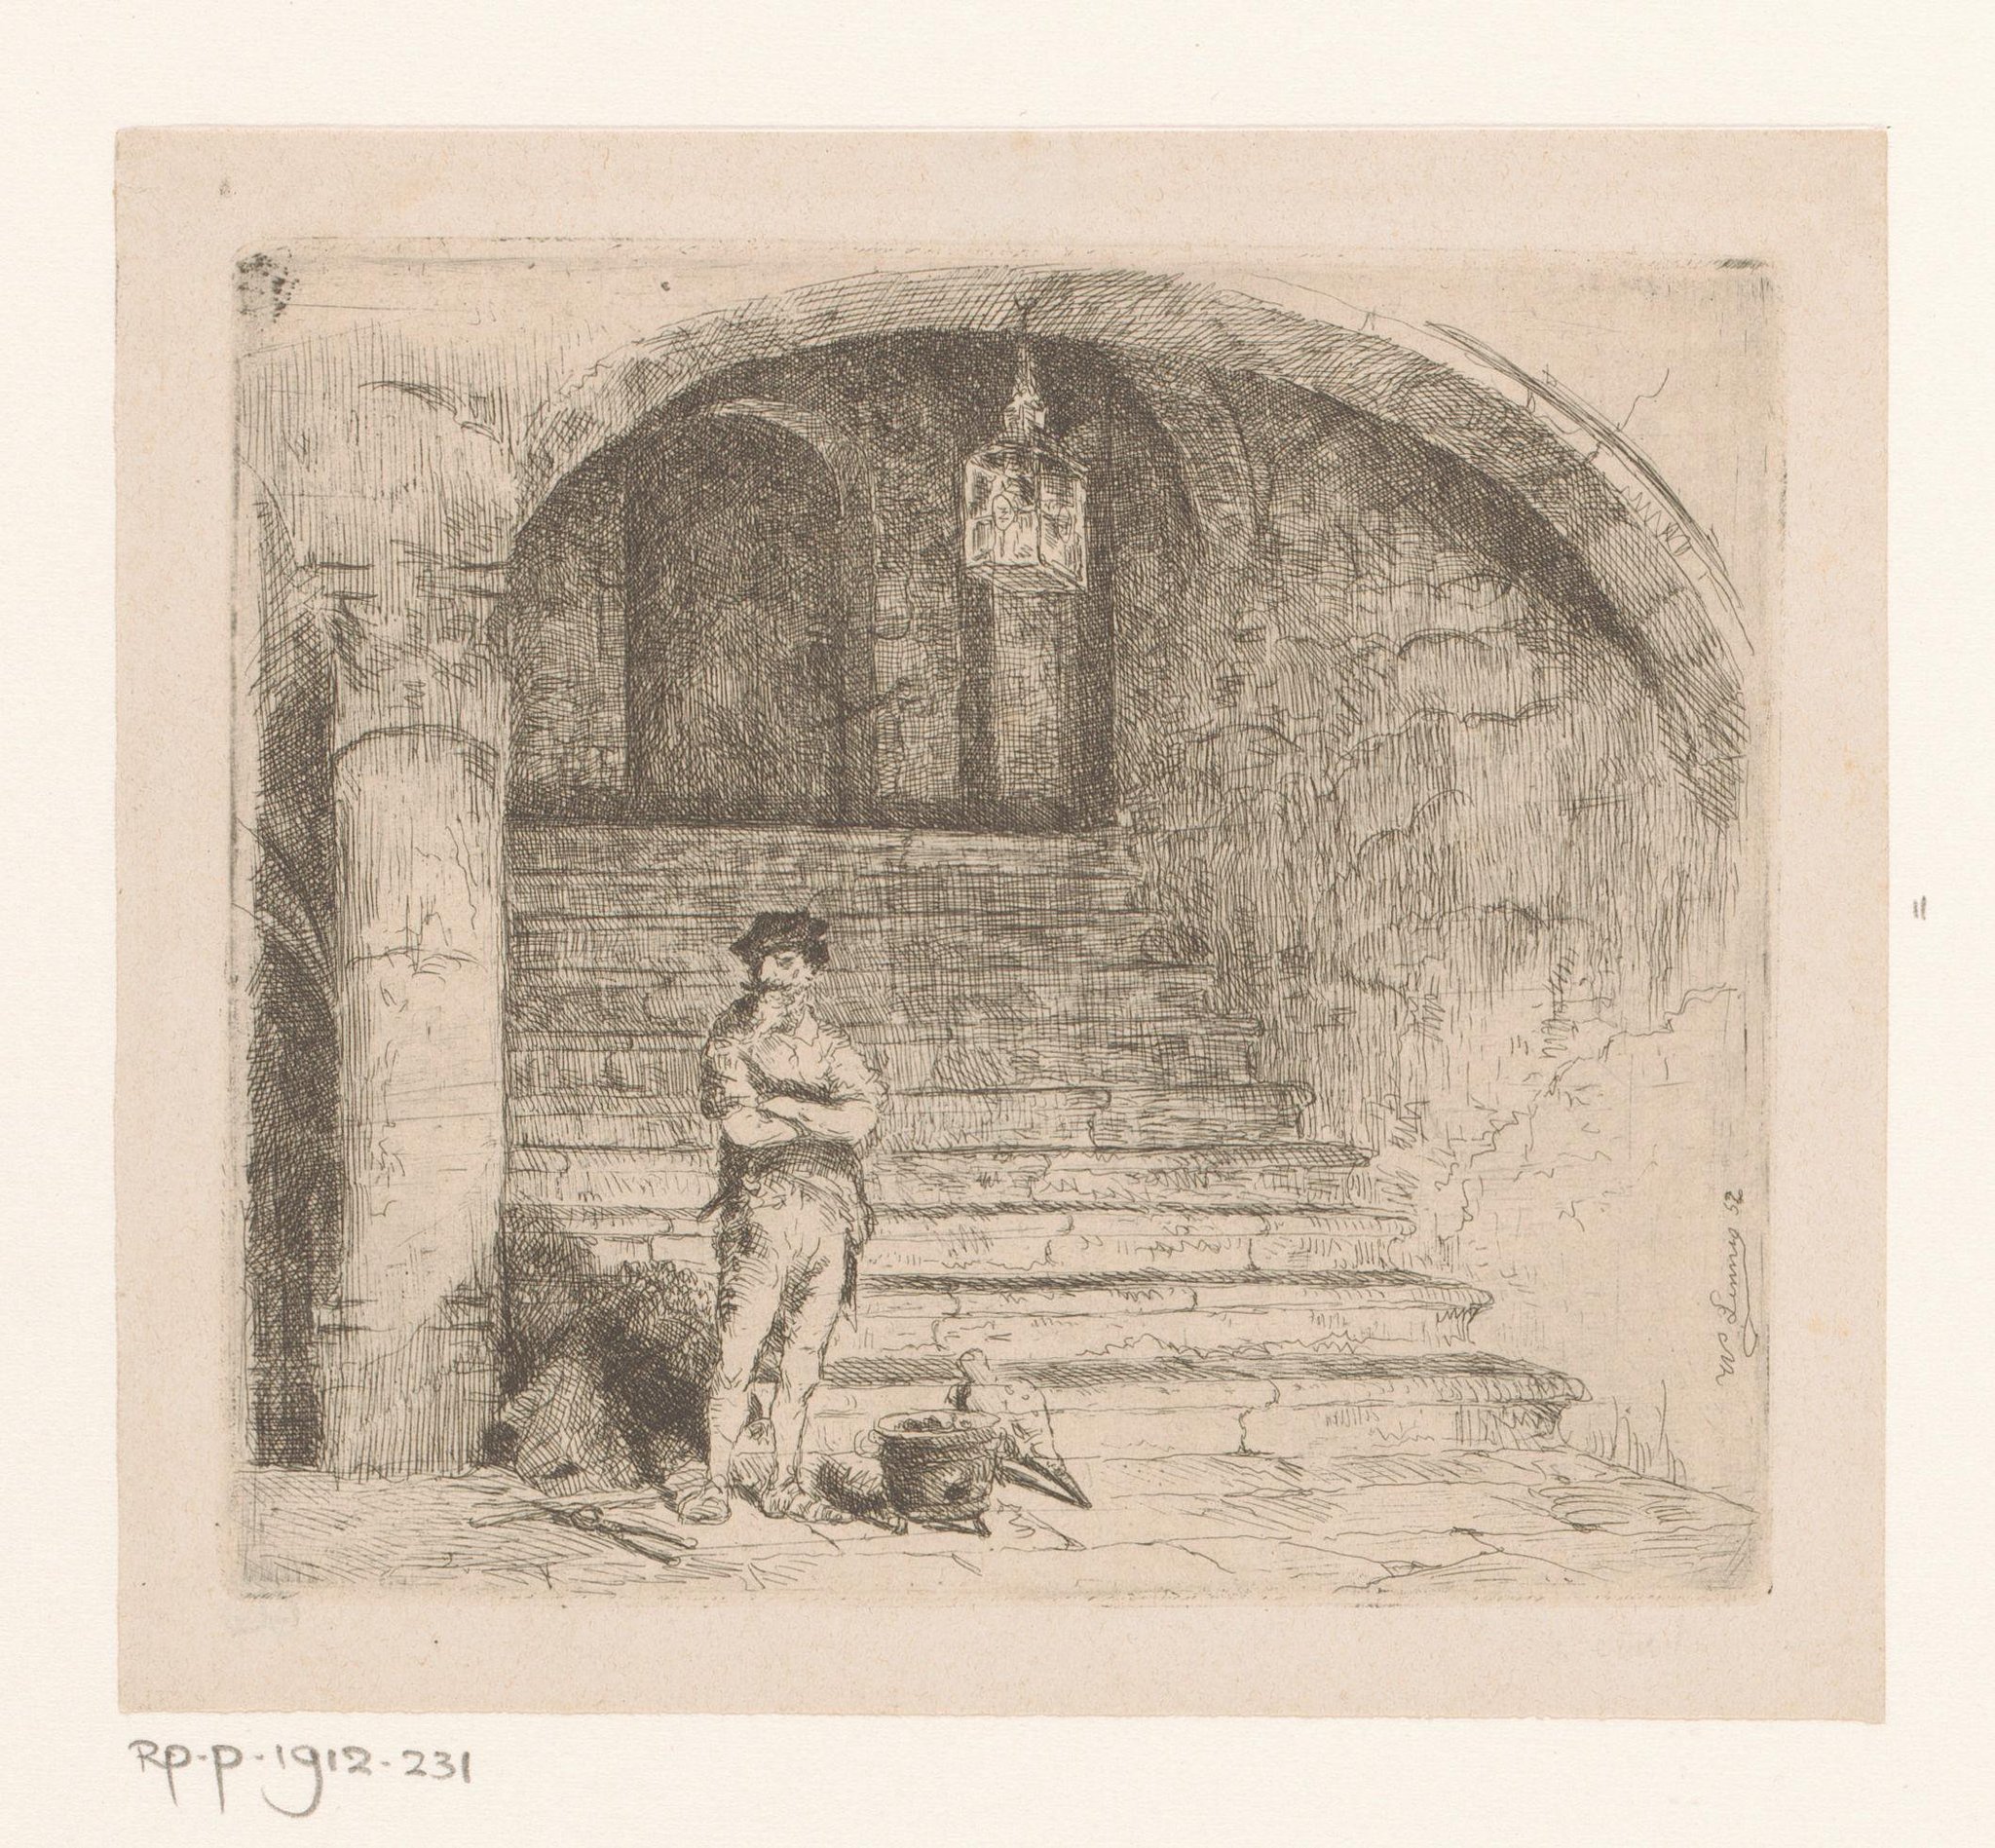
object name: print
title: Man staat naast een ketel bij een trap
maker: willem linnig (i)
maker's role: print maker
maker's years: 1819-1885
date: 1852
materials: paper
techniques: etching, intaglio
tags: adult woman, staircase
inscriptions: collector's mark: Lugt 1485, collector's mark: Lugt 2228